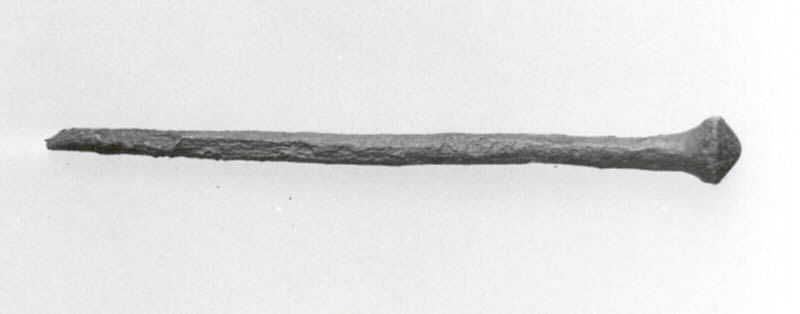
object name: pin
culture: iranian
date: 5000-2001 BCE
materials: copper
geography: iran